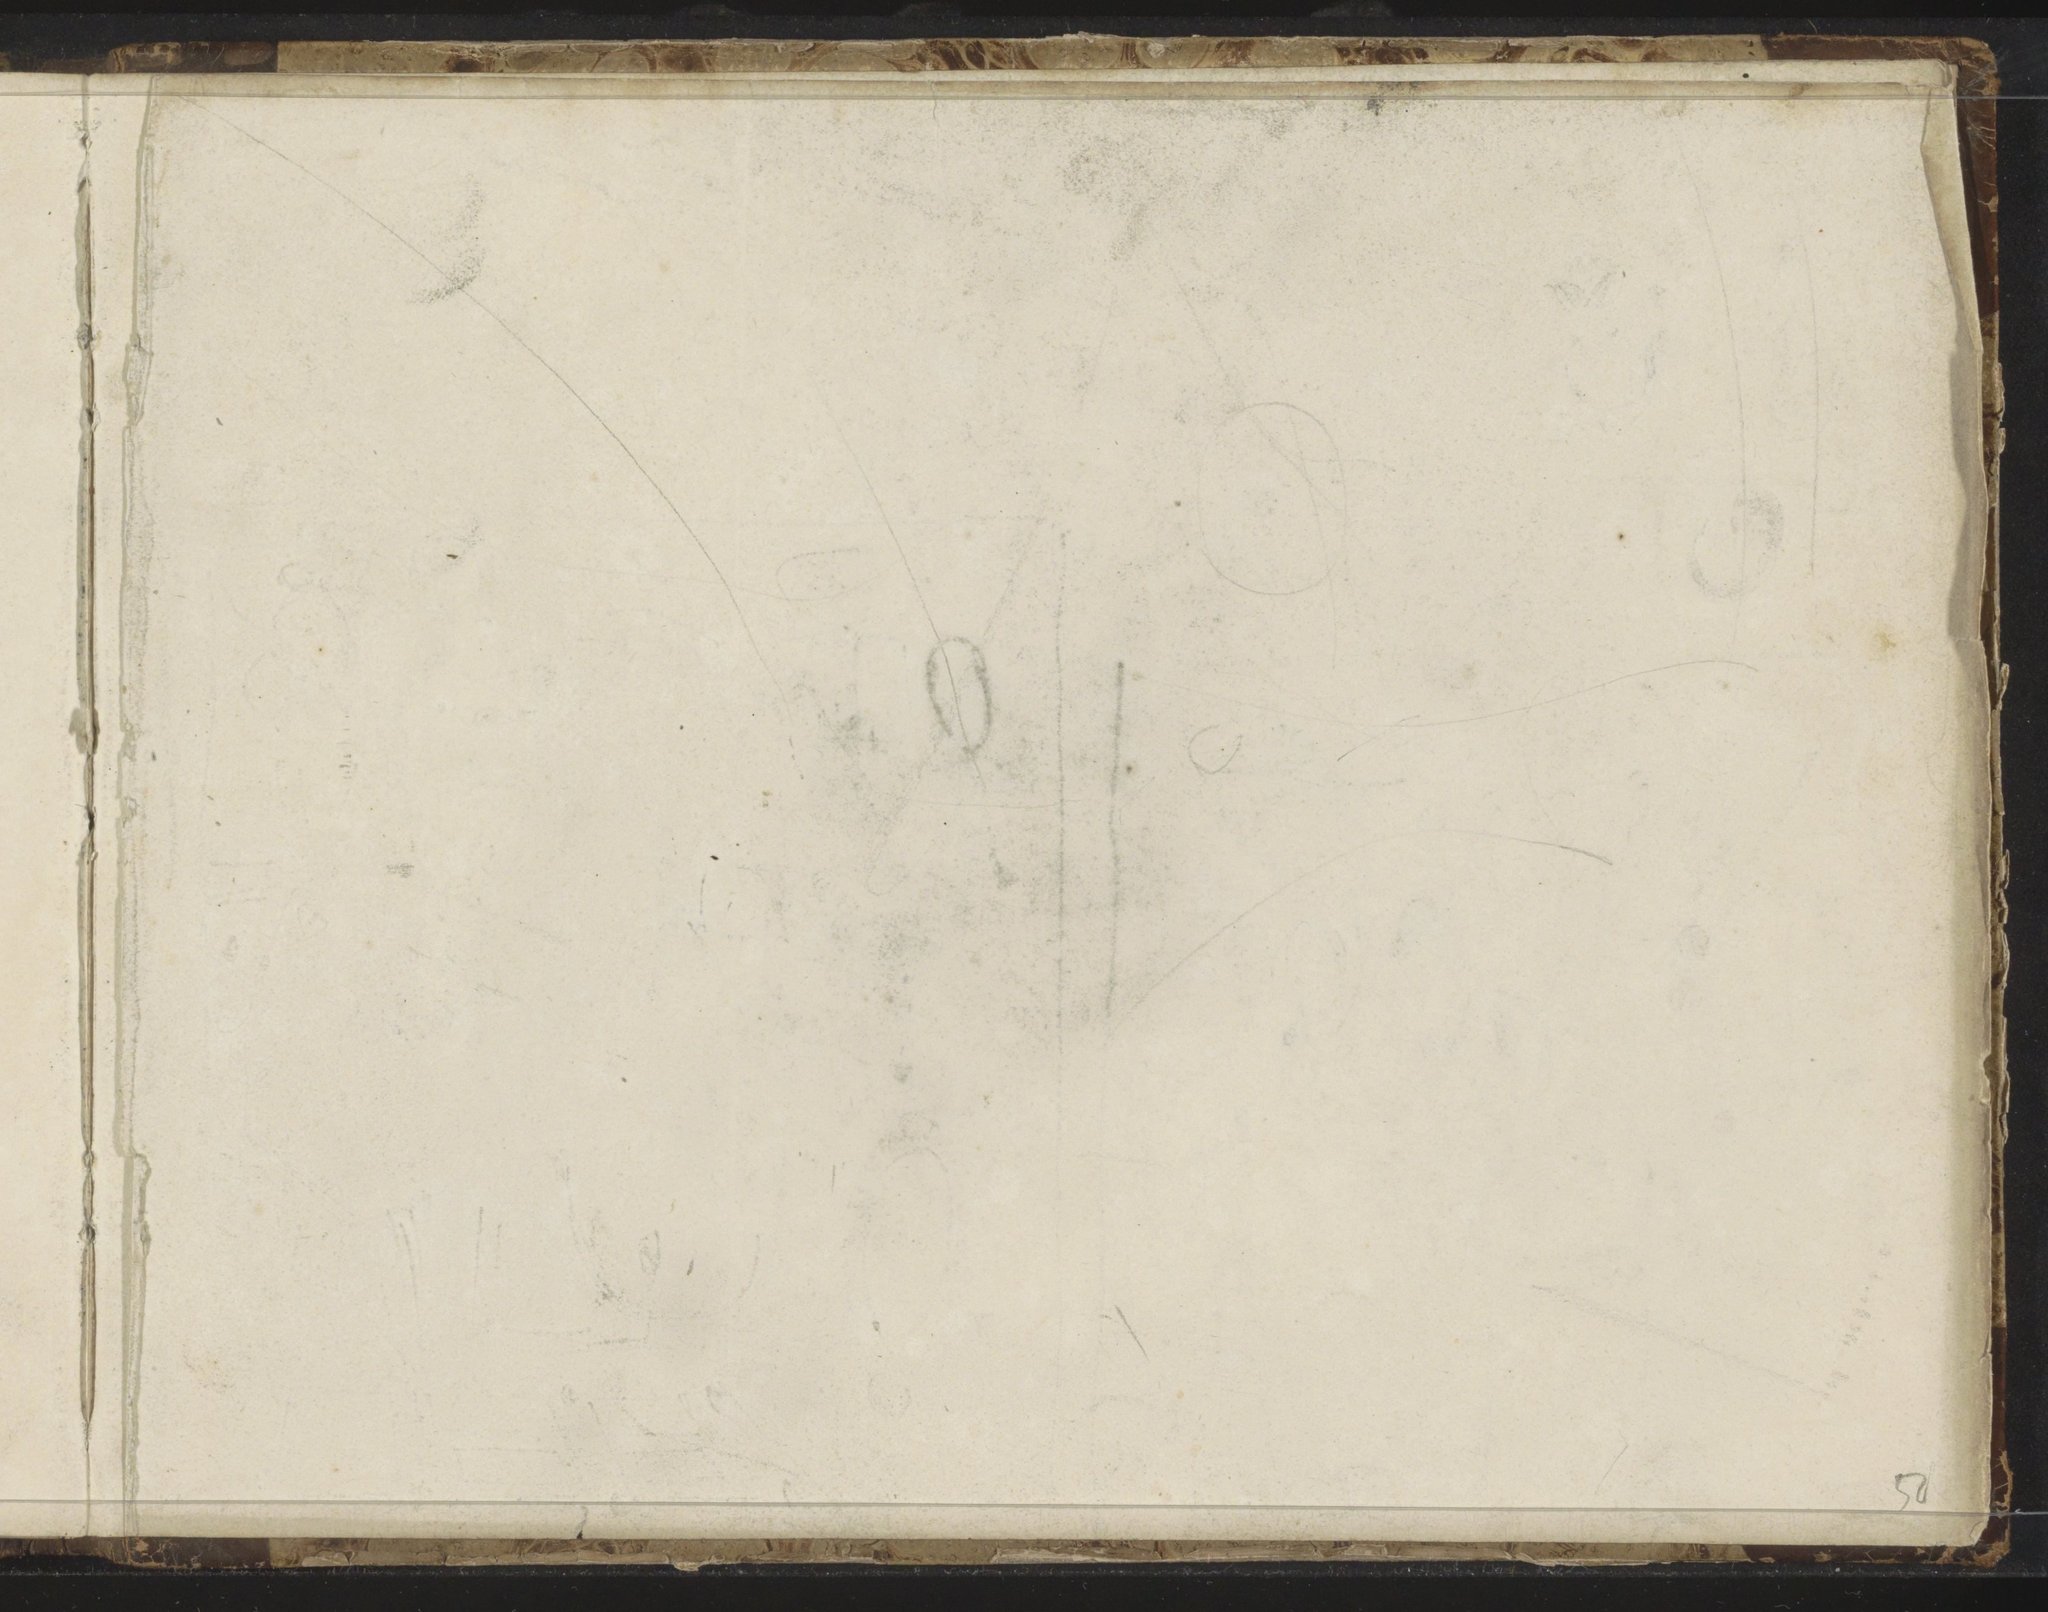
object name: sketchbook leaf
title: Studies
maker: willem hendrik schmidt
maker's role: draughtsman, painter, print maker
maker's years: 1809-1849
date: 1819-1849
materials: paper, pencil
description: Blad 50 recto uit een schetsboek met 52 bladen.